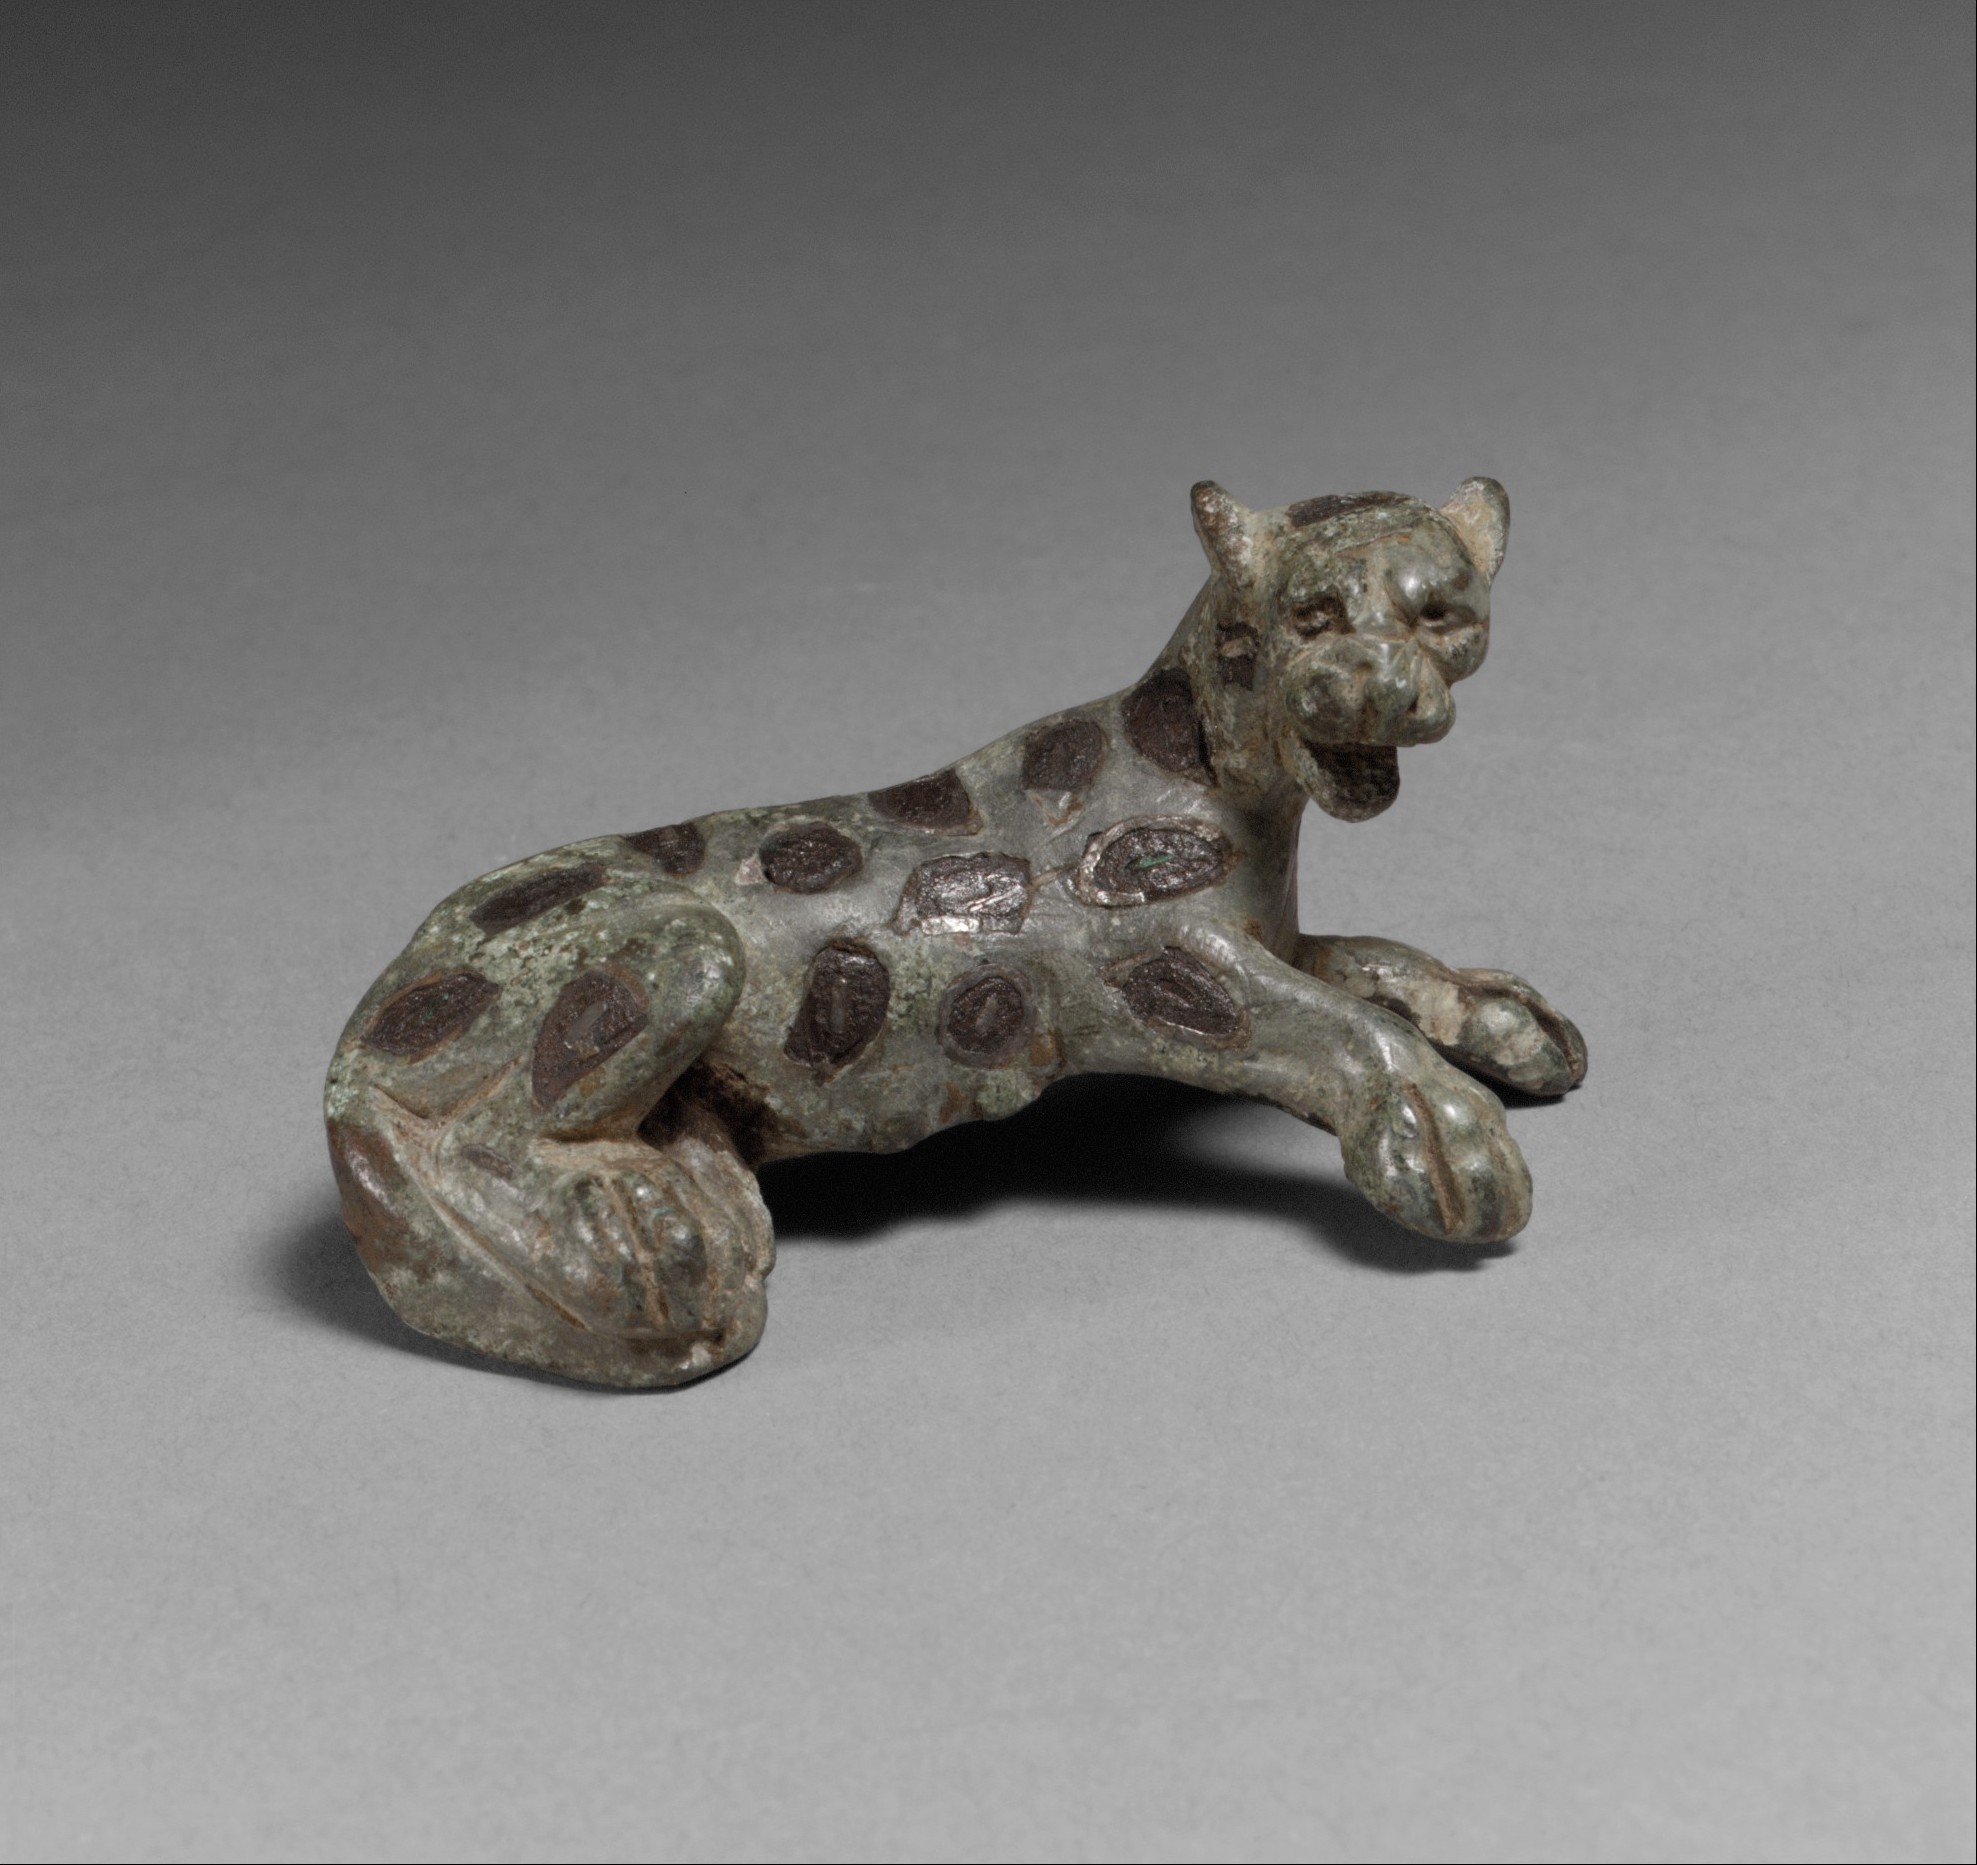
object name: figurine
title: Brooch in the Form of a Panther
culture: roman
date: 100-300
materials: copper alloy, niello, silver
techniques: inlay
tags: panthers